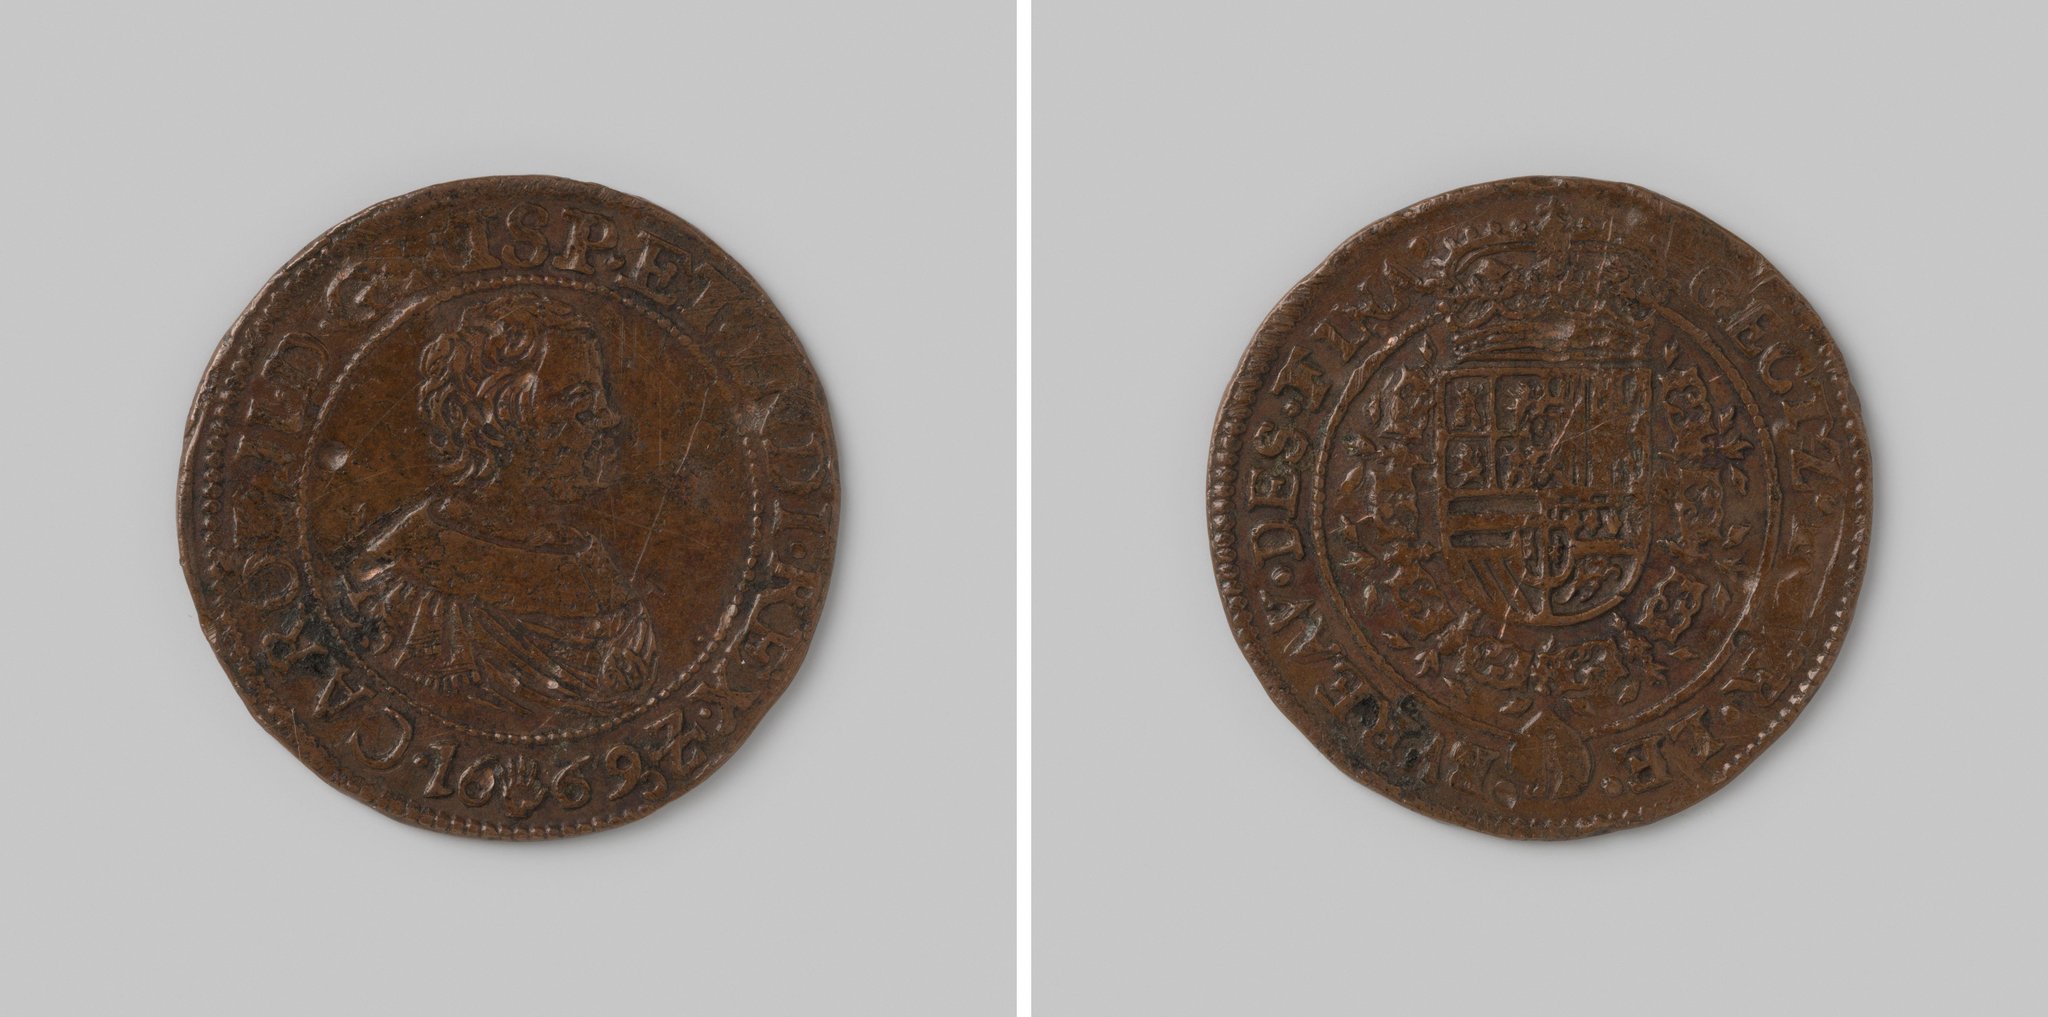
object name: history medal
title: Rekenpenning uit Antwerpen voor het Bureau van Financien 1669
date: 1669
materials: copper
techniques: striking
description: Koperen penning, op de voorzijde het borstbeeld van Karel II naar rechts met omschrift, op de keerzijde het gekroonde Spaanse wapenschild omhangen met de keten van het gulden vlies, met omschrift.